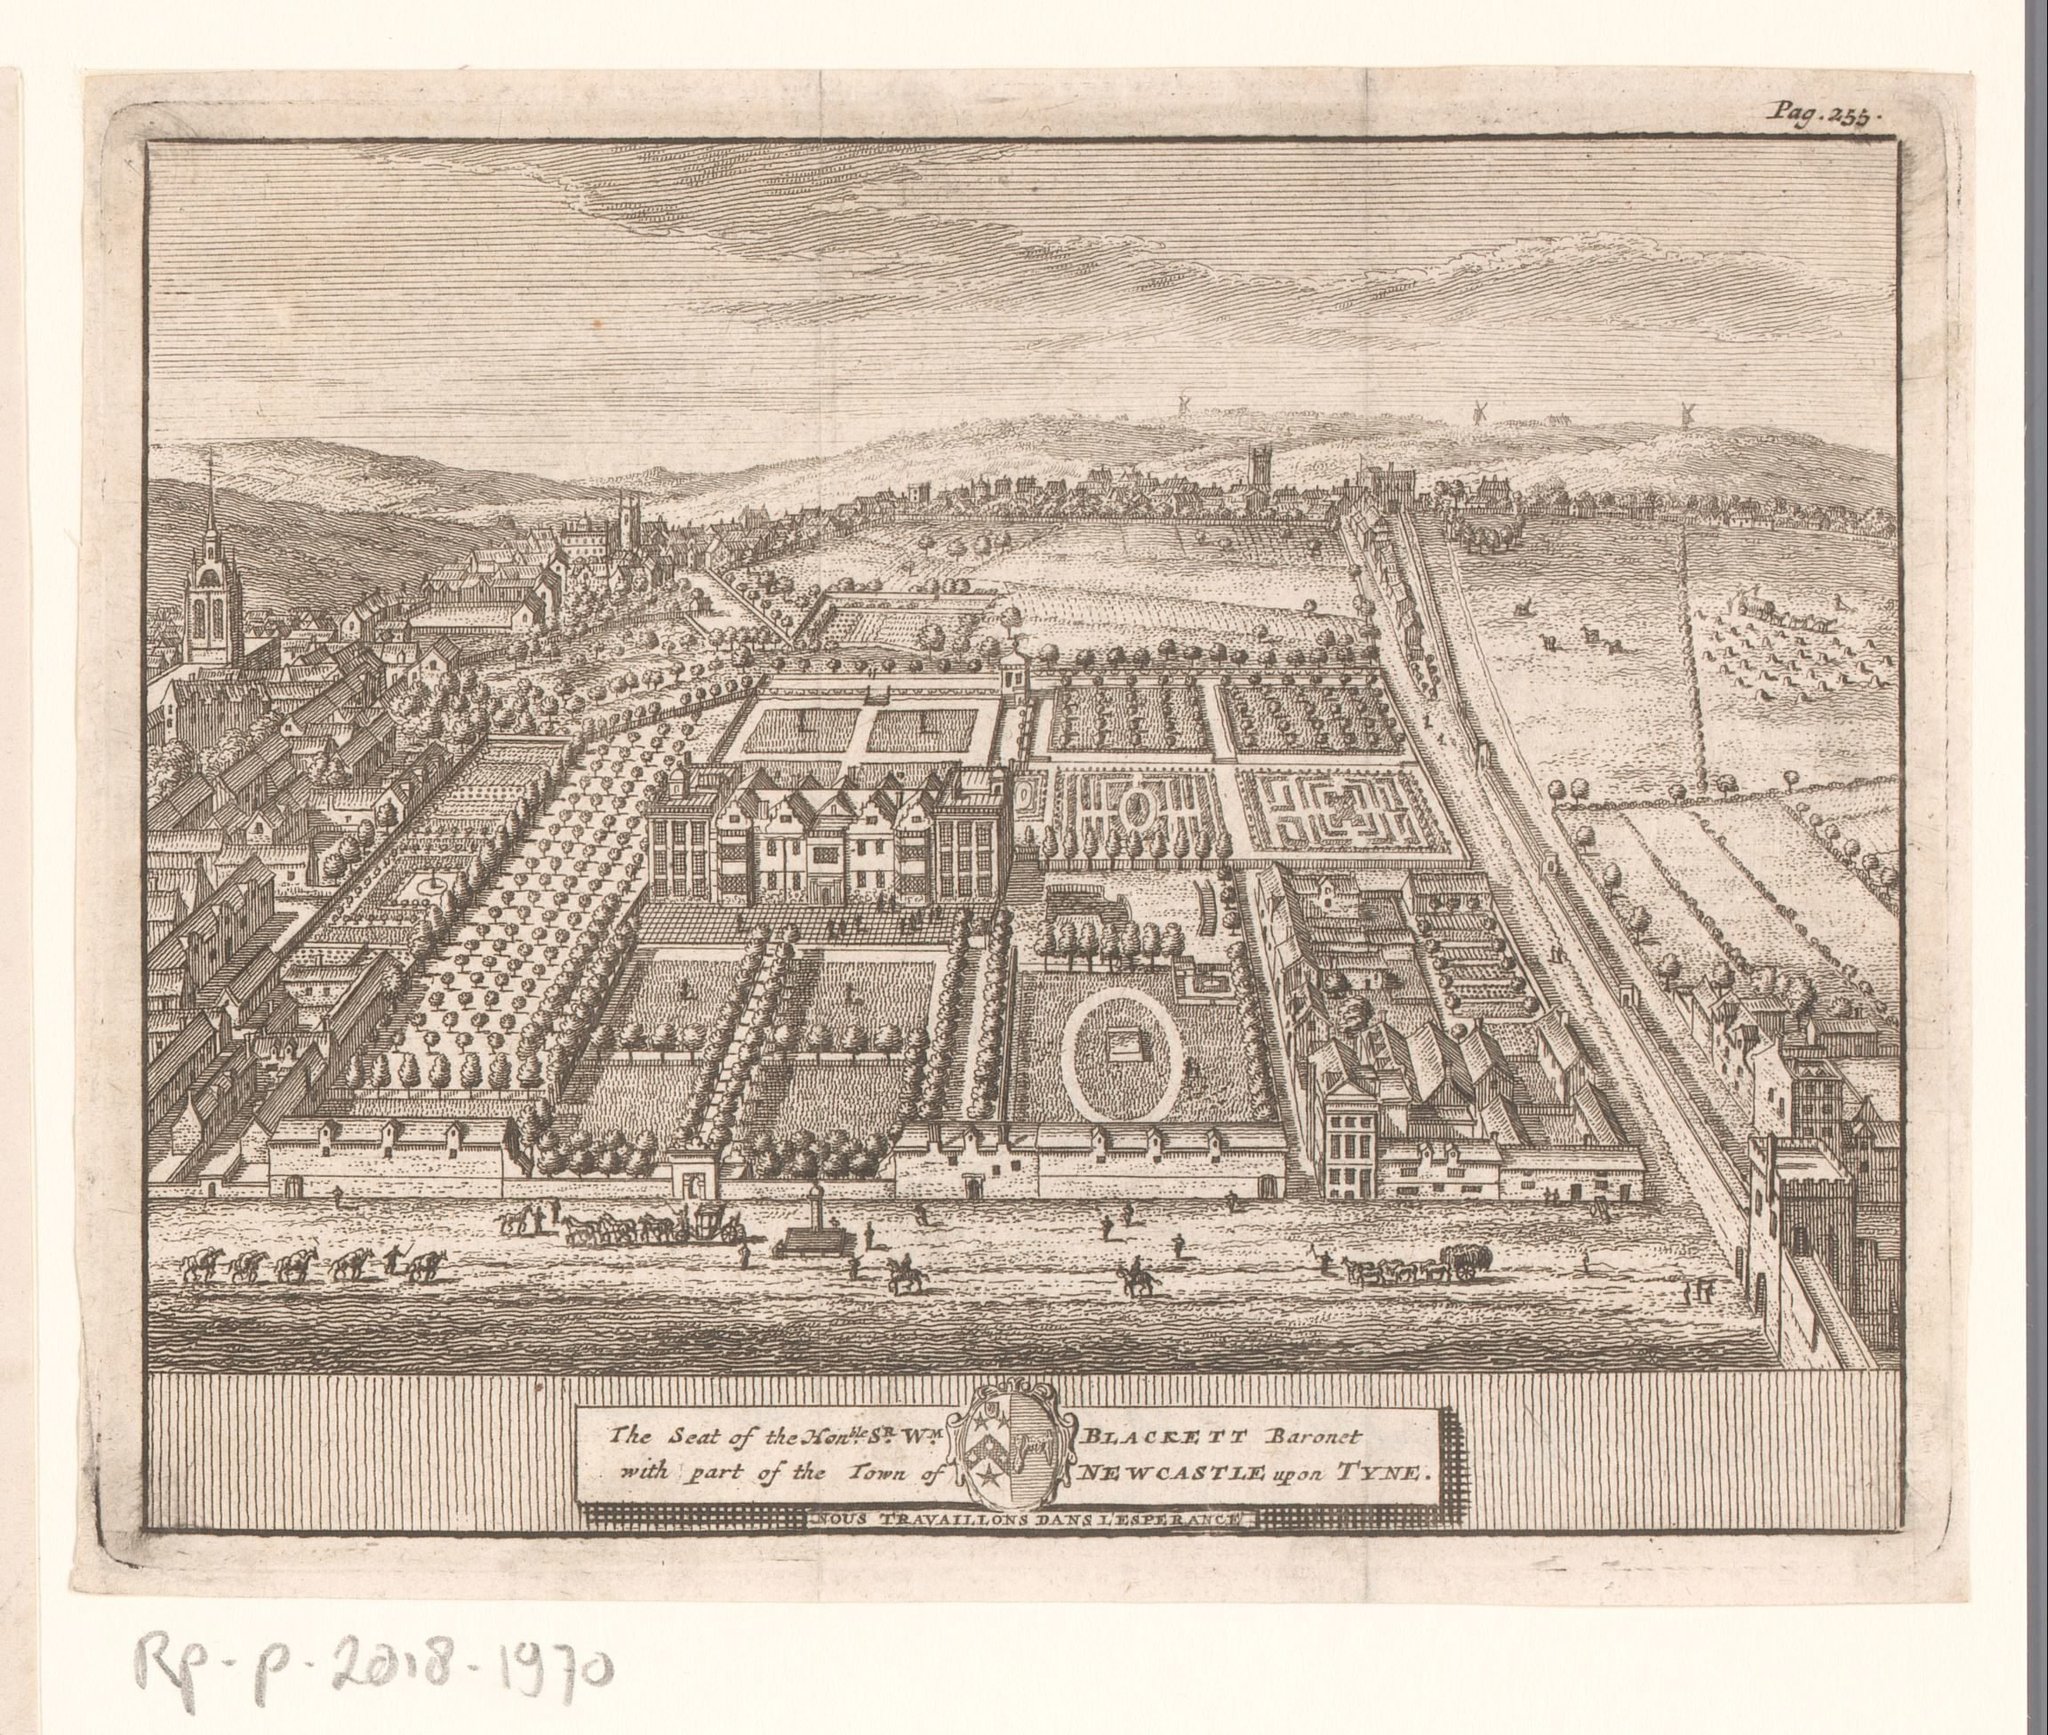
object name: print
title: Gezicht op het huis van Sir William Blacket, te Newcastle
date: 1707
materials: paper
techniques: etching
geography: leiden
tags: castle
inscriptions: collector's mark: Lugt 2228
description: Prent gebruikt in: Beeverell, James. Les Delices de la Grande Bretagne et de l'Irlande (...). Leiden: Pieter van der Aa, 1707.